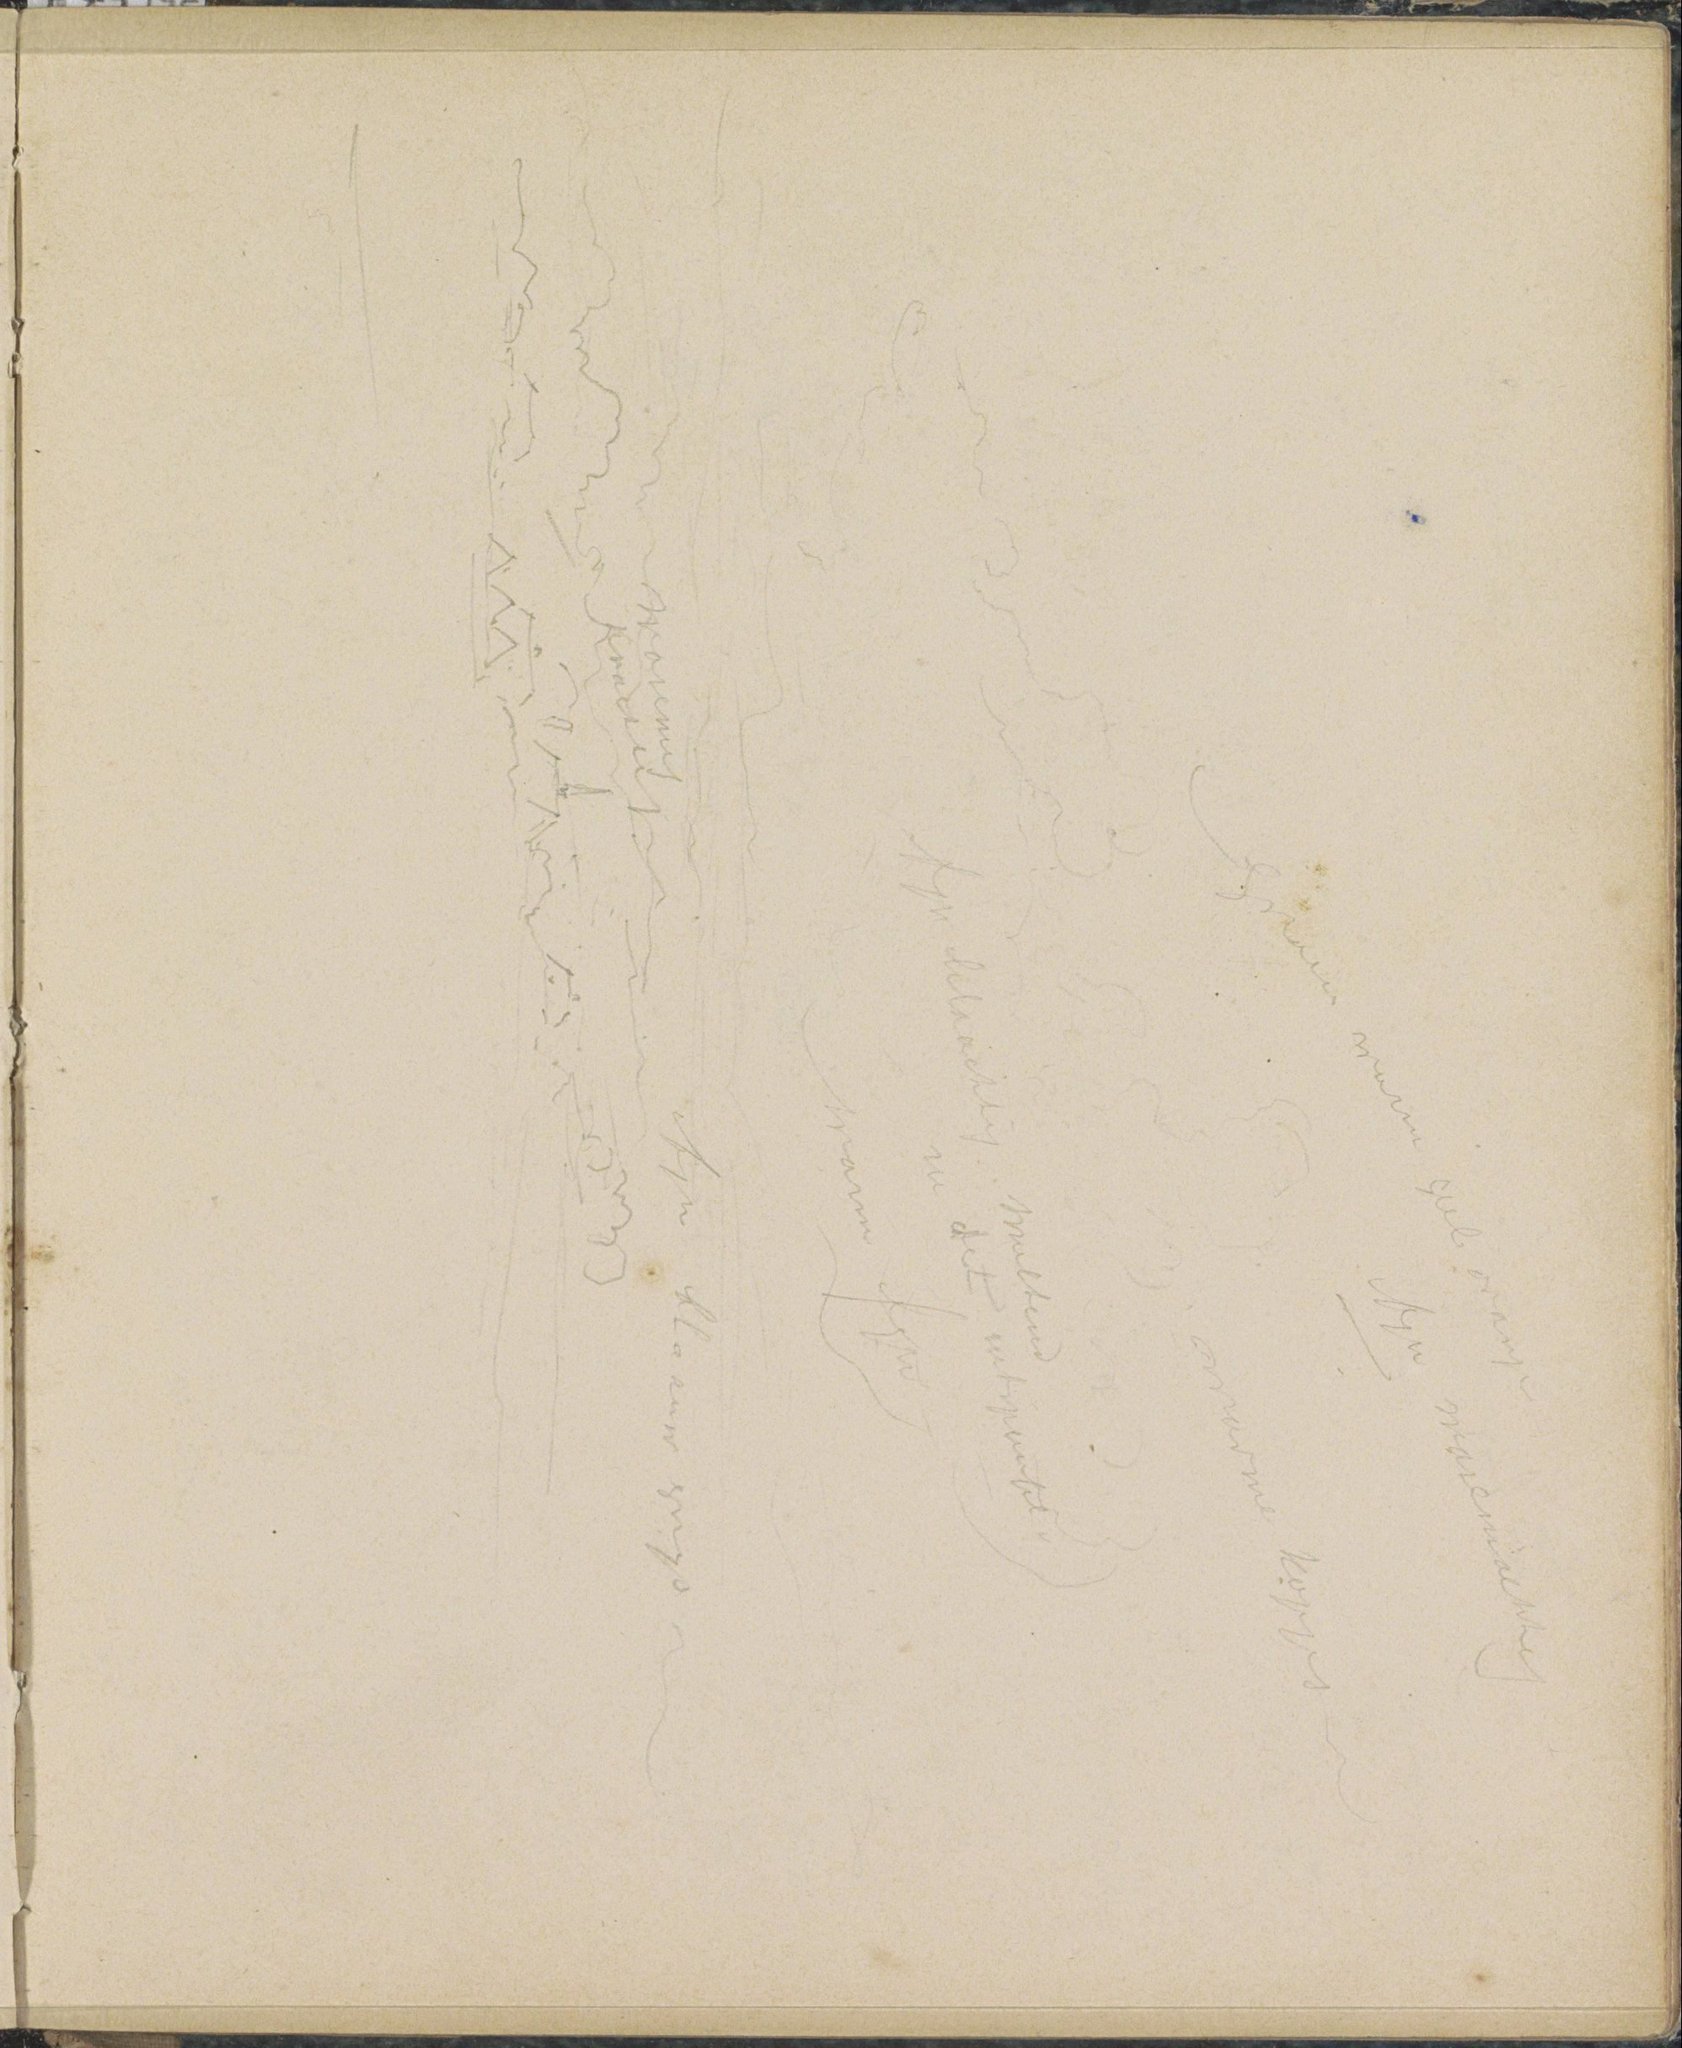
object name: sketchbook leaf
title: Gezicht op een dorp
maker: johannes tavenraat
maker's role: draughtsman, painter, print maker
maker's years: 1809-1881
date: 1841-1853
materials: paper, pencil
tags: city-view, and landscape with man-made constructions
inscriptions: kleurnotitie, handgeschreven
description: Blad 71 recto uit een schetsboek met 87 bladen.